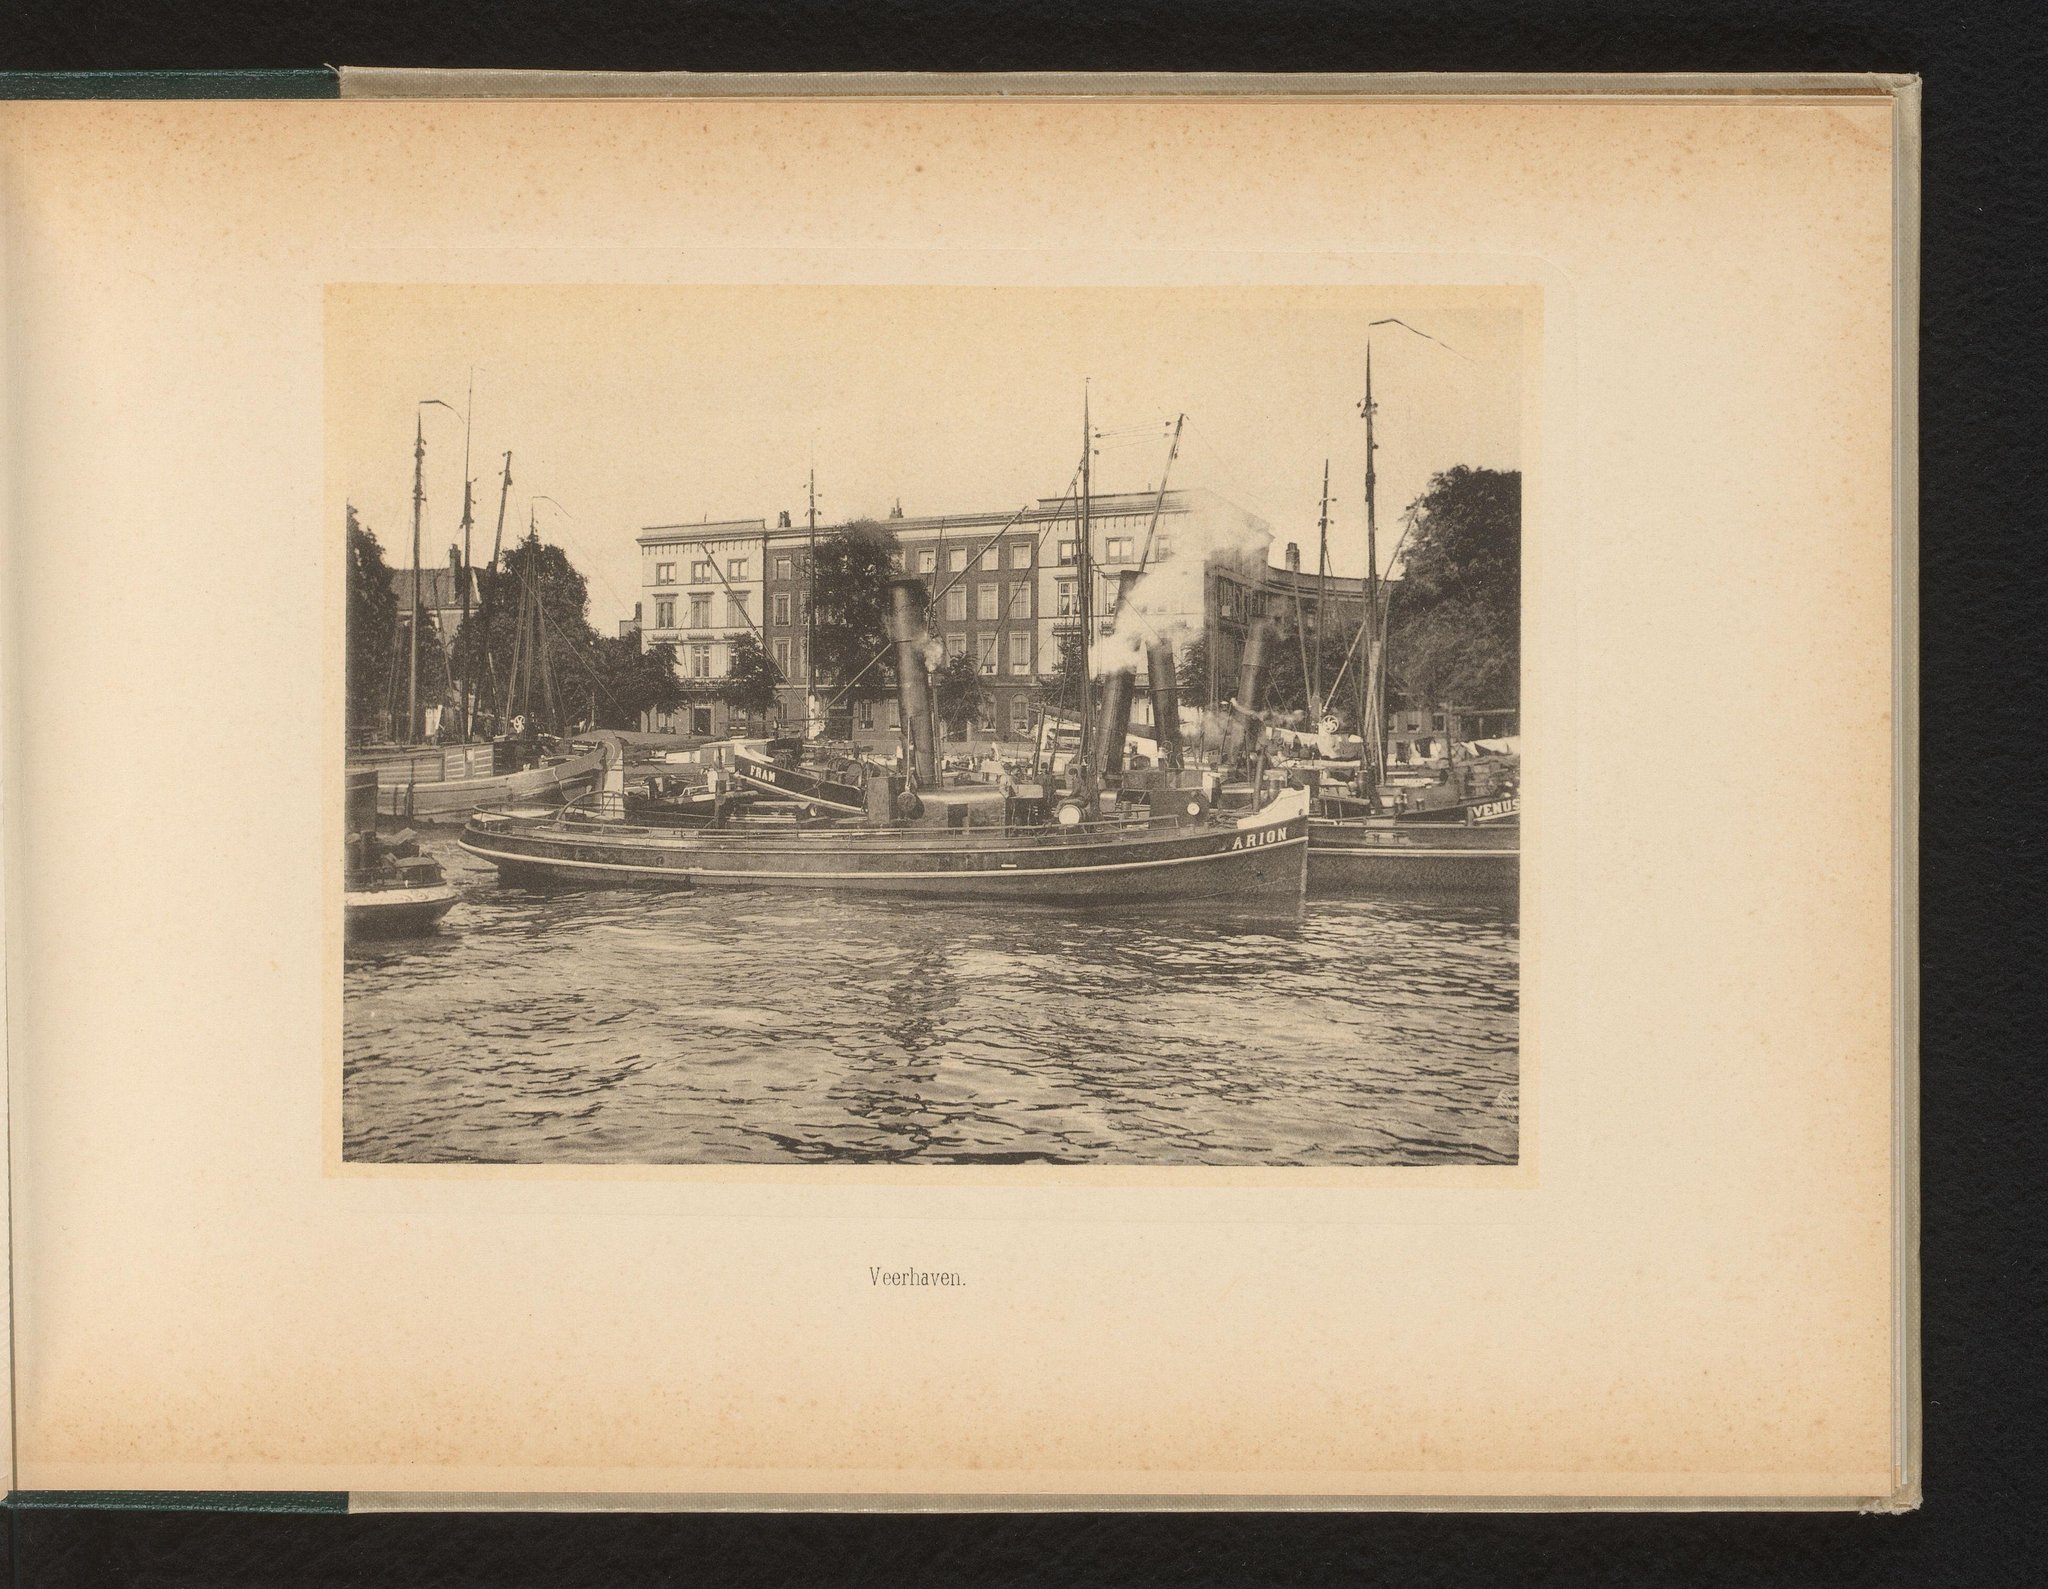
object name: page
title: Veerhaven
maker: Anonymous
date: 1902-1907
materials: paper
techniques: photograph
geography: rotterdam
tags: harbour